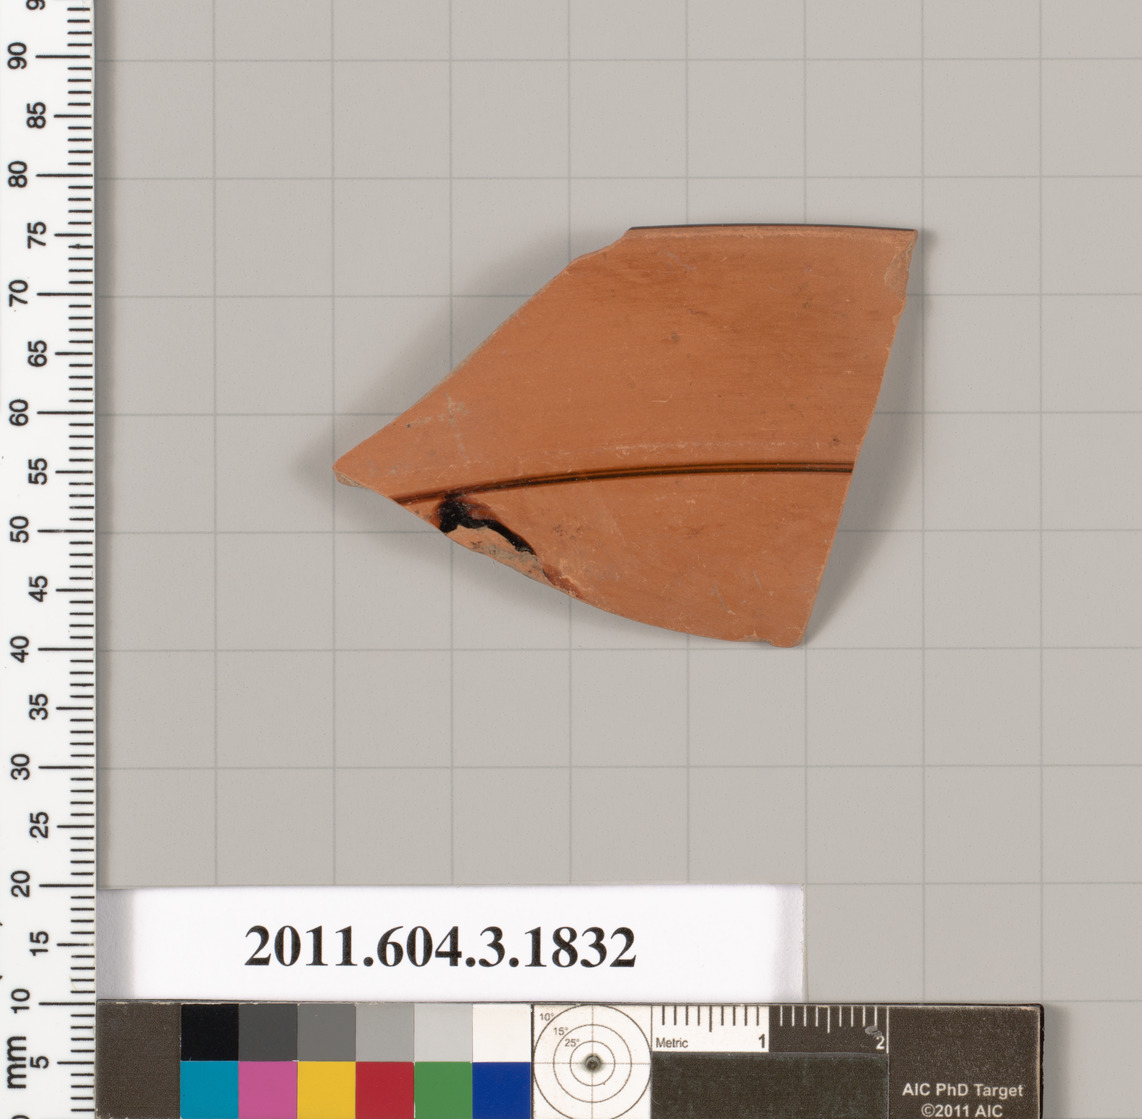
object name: kylix fragment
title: Terracotta fragment of a kylix: Lip cup (drinking cup)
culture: greek, attic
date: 560-525 BCE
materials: terracotta